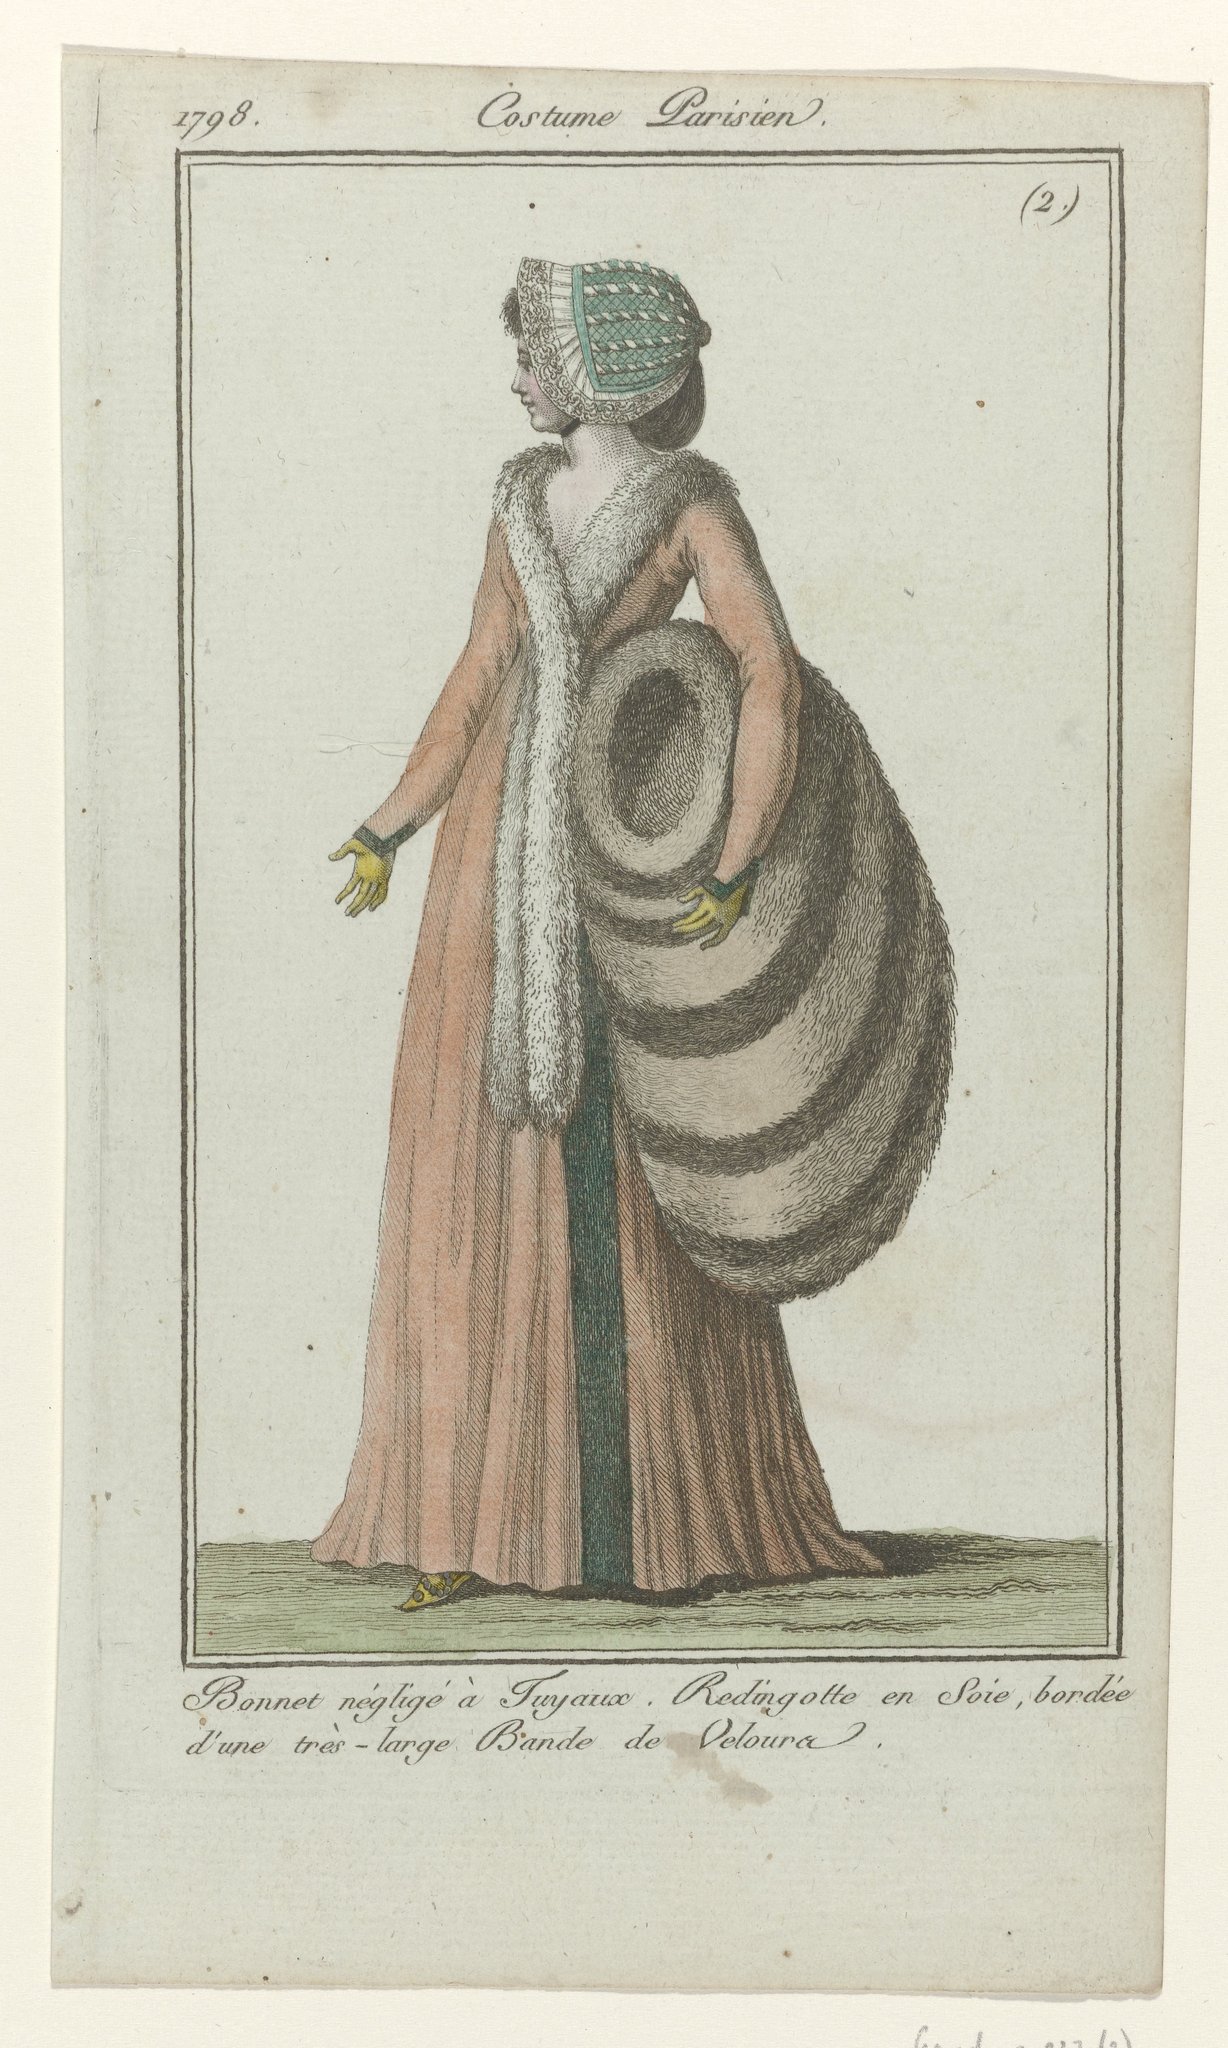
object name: fashion print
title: Journal des Dames et des Modes, Costume Parisien, 15 janvier 1798, (2) : Bonnet négligé à Tuyaux (...)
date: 1798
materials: paper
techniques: engraving, hand coloring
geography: paris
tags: dress, gown: redingote (+ women's clothes), neck-gear ~ clothing (palatine) (+ women's clothes), head-gear: cap (+ women's clothes), fashion plates, shoes, sandals (+ women's clothes), gloves, mittens, etc. (+ women's clothes), muff (+ fur used for clothes)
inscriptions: caption: ‘Bonnet négligé à Tuyaux. Redingotte en Soie, bordée d'une très-large Bande de Velours.’, title: ‘Costume Parisien.’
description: 'Bonnet négligé à Tuyaux'. Redingote van zijde, afgezet met een zeer brede band van fluweel. Om de schouders een 'palatine' van bont. Verdere accessoires: grote gestreepte mof van bont, handschoenen, schoen met puntige neus en gesp(?). De prent maakt deel uit van het modetijdschrift Journal des Dames et des Modes, uitgegeven door Sellèque, Parijs, 1797-1839.